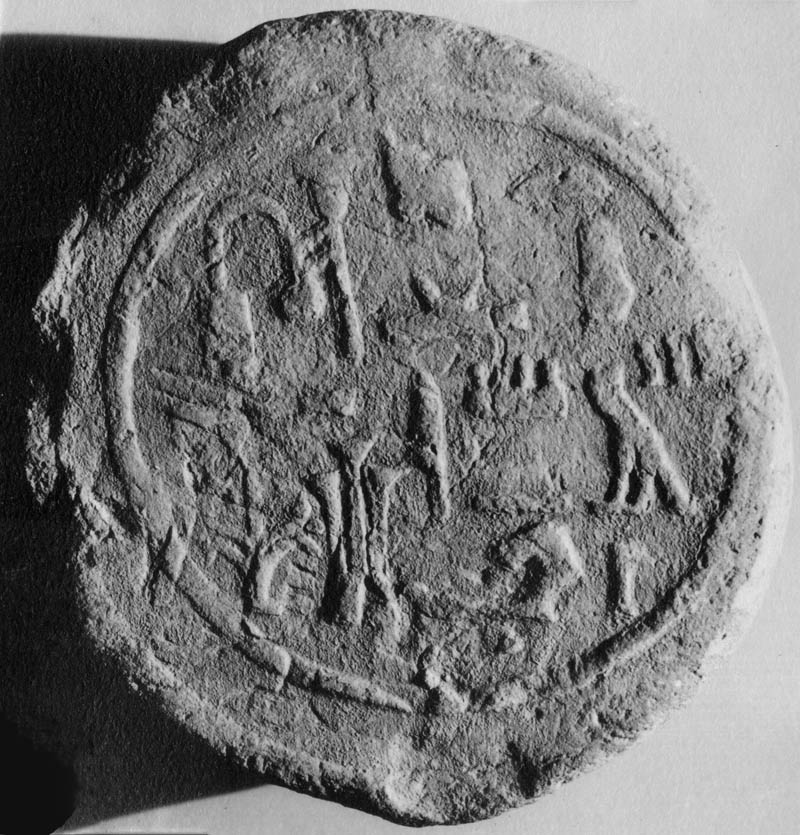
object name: cone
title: Funerary Cone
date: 1550-1295 BCE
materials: pottery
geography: egypt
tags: hieroglyphs